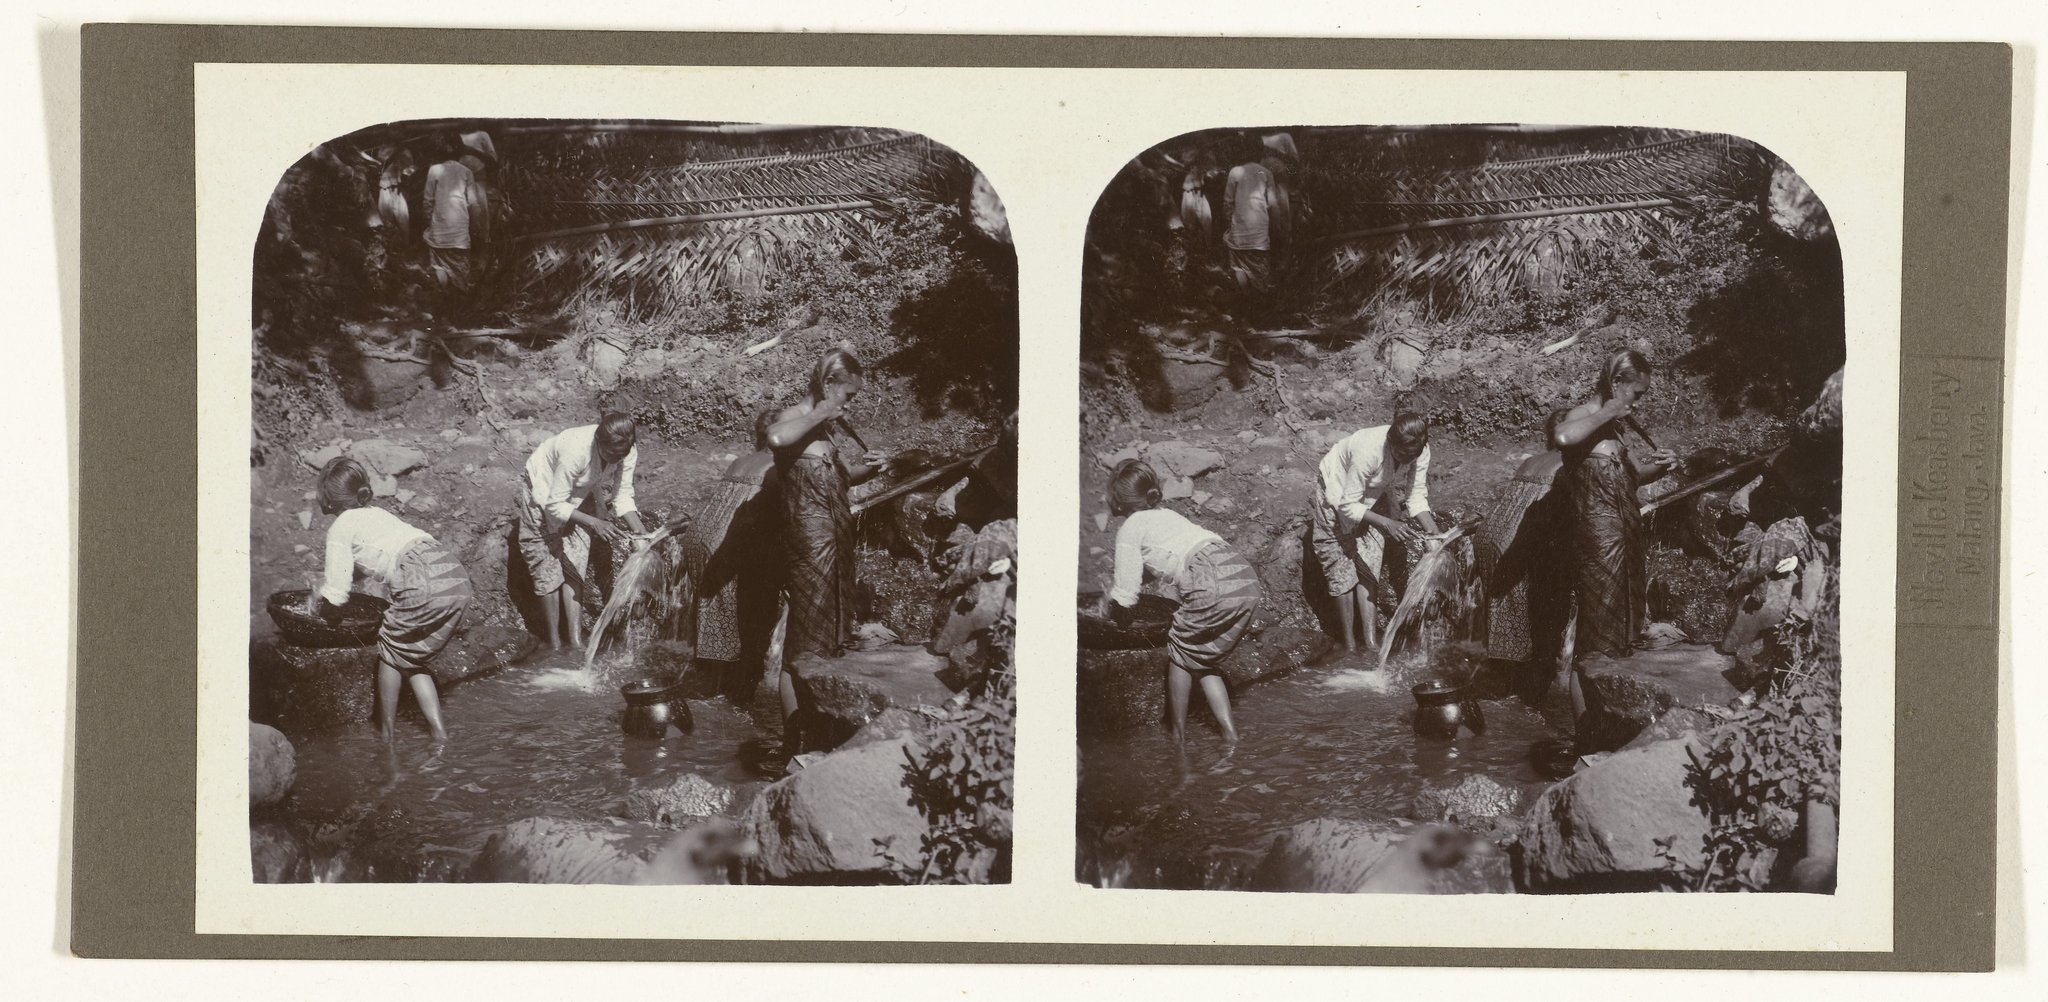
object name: photograph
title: S 1 No 6. Algemeene wasch.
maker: neville keasberry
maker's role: fotograaf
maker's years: 1866-1944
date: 1900-1935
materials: cardboard, paper, photographic support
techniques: albumen print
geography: malang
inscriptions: signature: ‘Neville Keasberry, Malang (Java)’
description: Javaanse vrouwen sorteren tabaksbladeren in een hal, de groep staat onder toezicht van een europese man die enkele bladeren inspecteert.